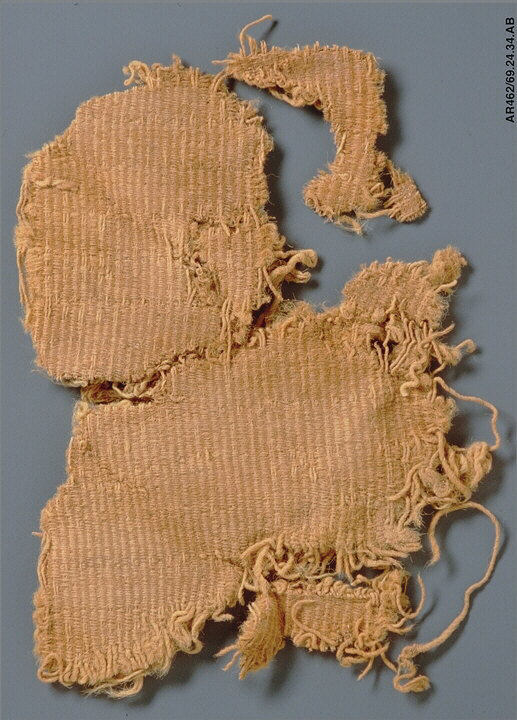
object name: textile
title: Textile fragment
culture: sasanian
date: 501-600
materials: wool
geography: iran